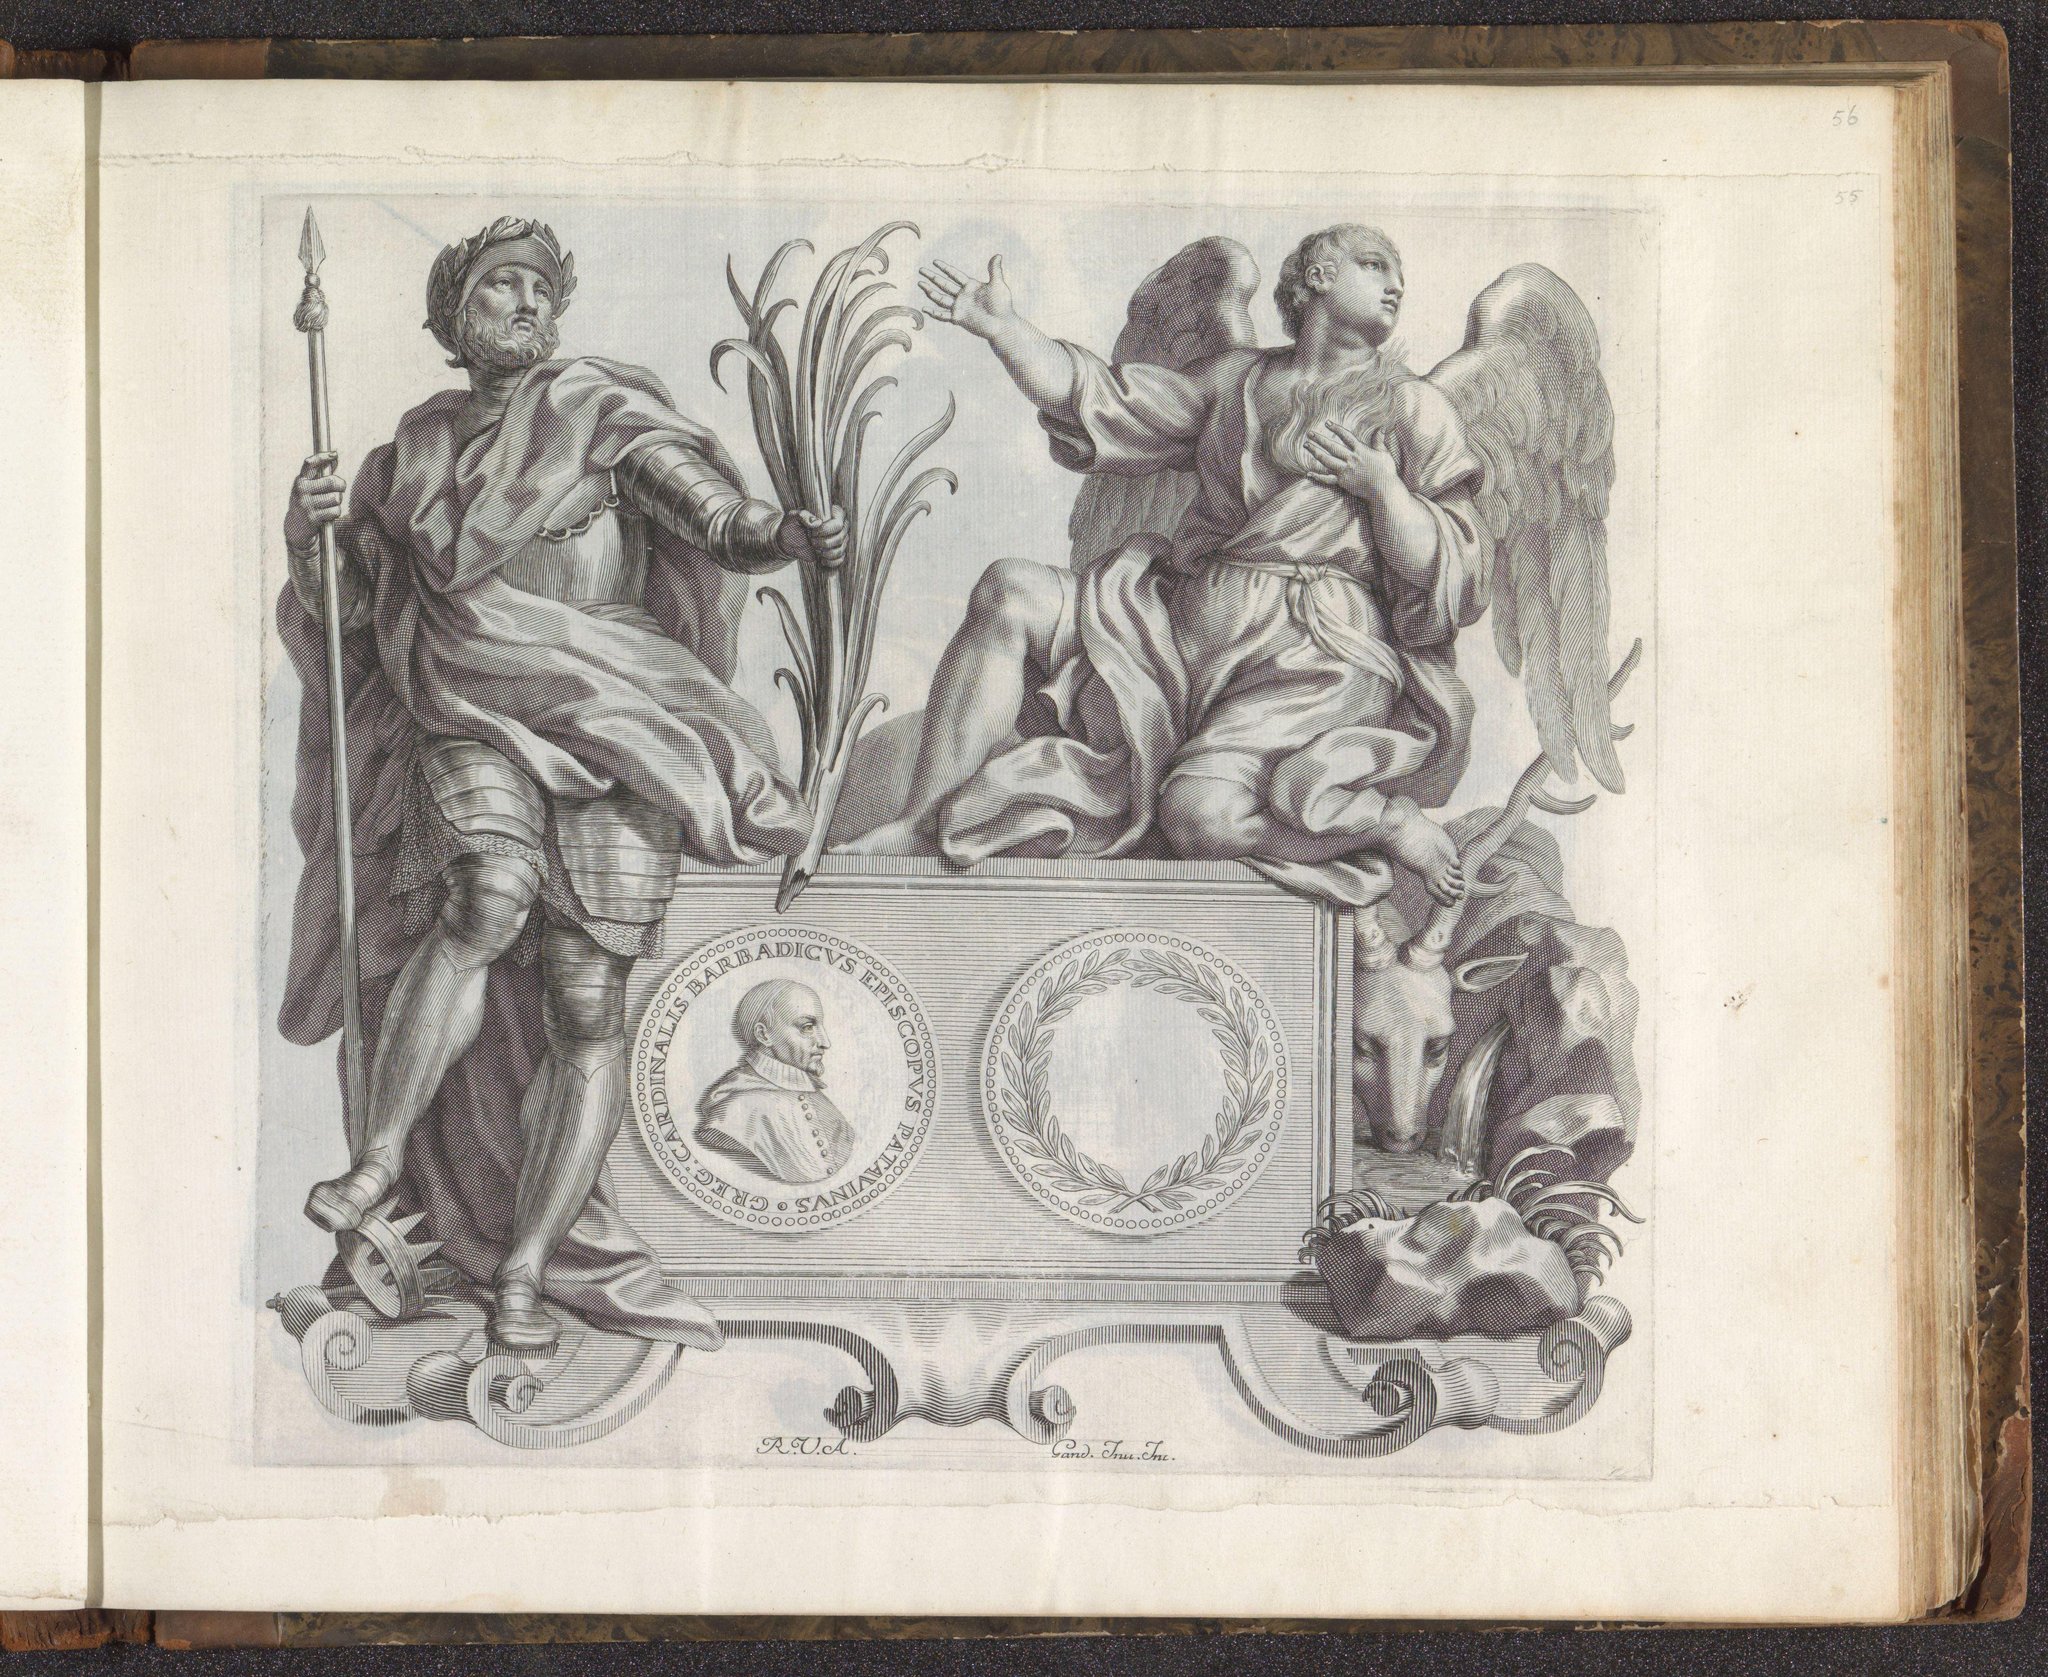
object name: print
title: Numismata virorum illustrium ex Barbadica gente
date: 1673-1743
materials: paper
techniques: engraving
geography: rome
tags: venice, fides (faith) as roman personification, hoofed animals: deer, the book of psalms (with book chapter:verse), 'desiderio verso iddio' (ripa), despising the world; 'dispregio del mondo', 'disprezzo et distruttione de i piaceri & cattivi affetti' (ripa), medal (considered as a piece of sculpture, regardless of its specific function), martyr(s) (often with palm-branches), angels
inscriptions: collector's mark: Lugt 2228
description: Voetstuk in de vorm van een cartouche. Daarop een medaillon met op de voorkant het portret van Gregorio Barbarigo. Op de achterkant een lauwerkrans. Links van het voetstuk een geharnaste man. Zijn hoofd gekroond met een lauwerkrans en gericht naar de hemel. In zijn handen een spies en palmtak. Op zijn hoofd een lauwerkrans. Hij is het symbool voor de Minachting voor de wereld. Knielend op het voetstuk zit Verlangen tot God: een engel uit wiens borst een vlam opschiet. Ze heeft het gezicht naar de hemel gekeerd. Rechts drinkt een hert water uit een bron. Het verwijst naar psalm 42: 'Zoals een hinde smacht naar stromend water, zo smacht mijn ziel naar u, o God'. De prent maakt deel uit van een album.